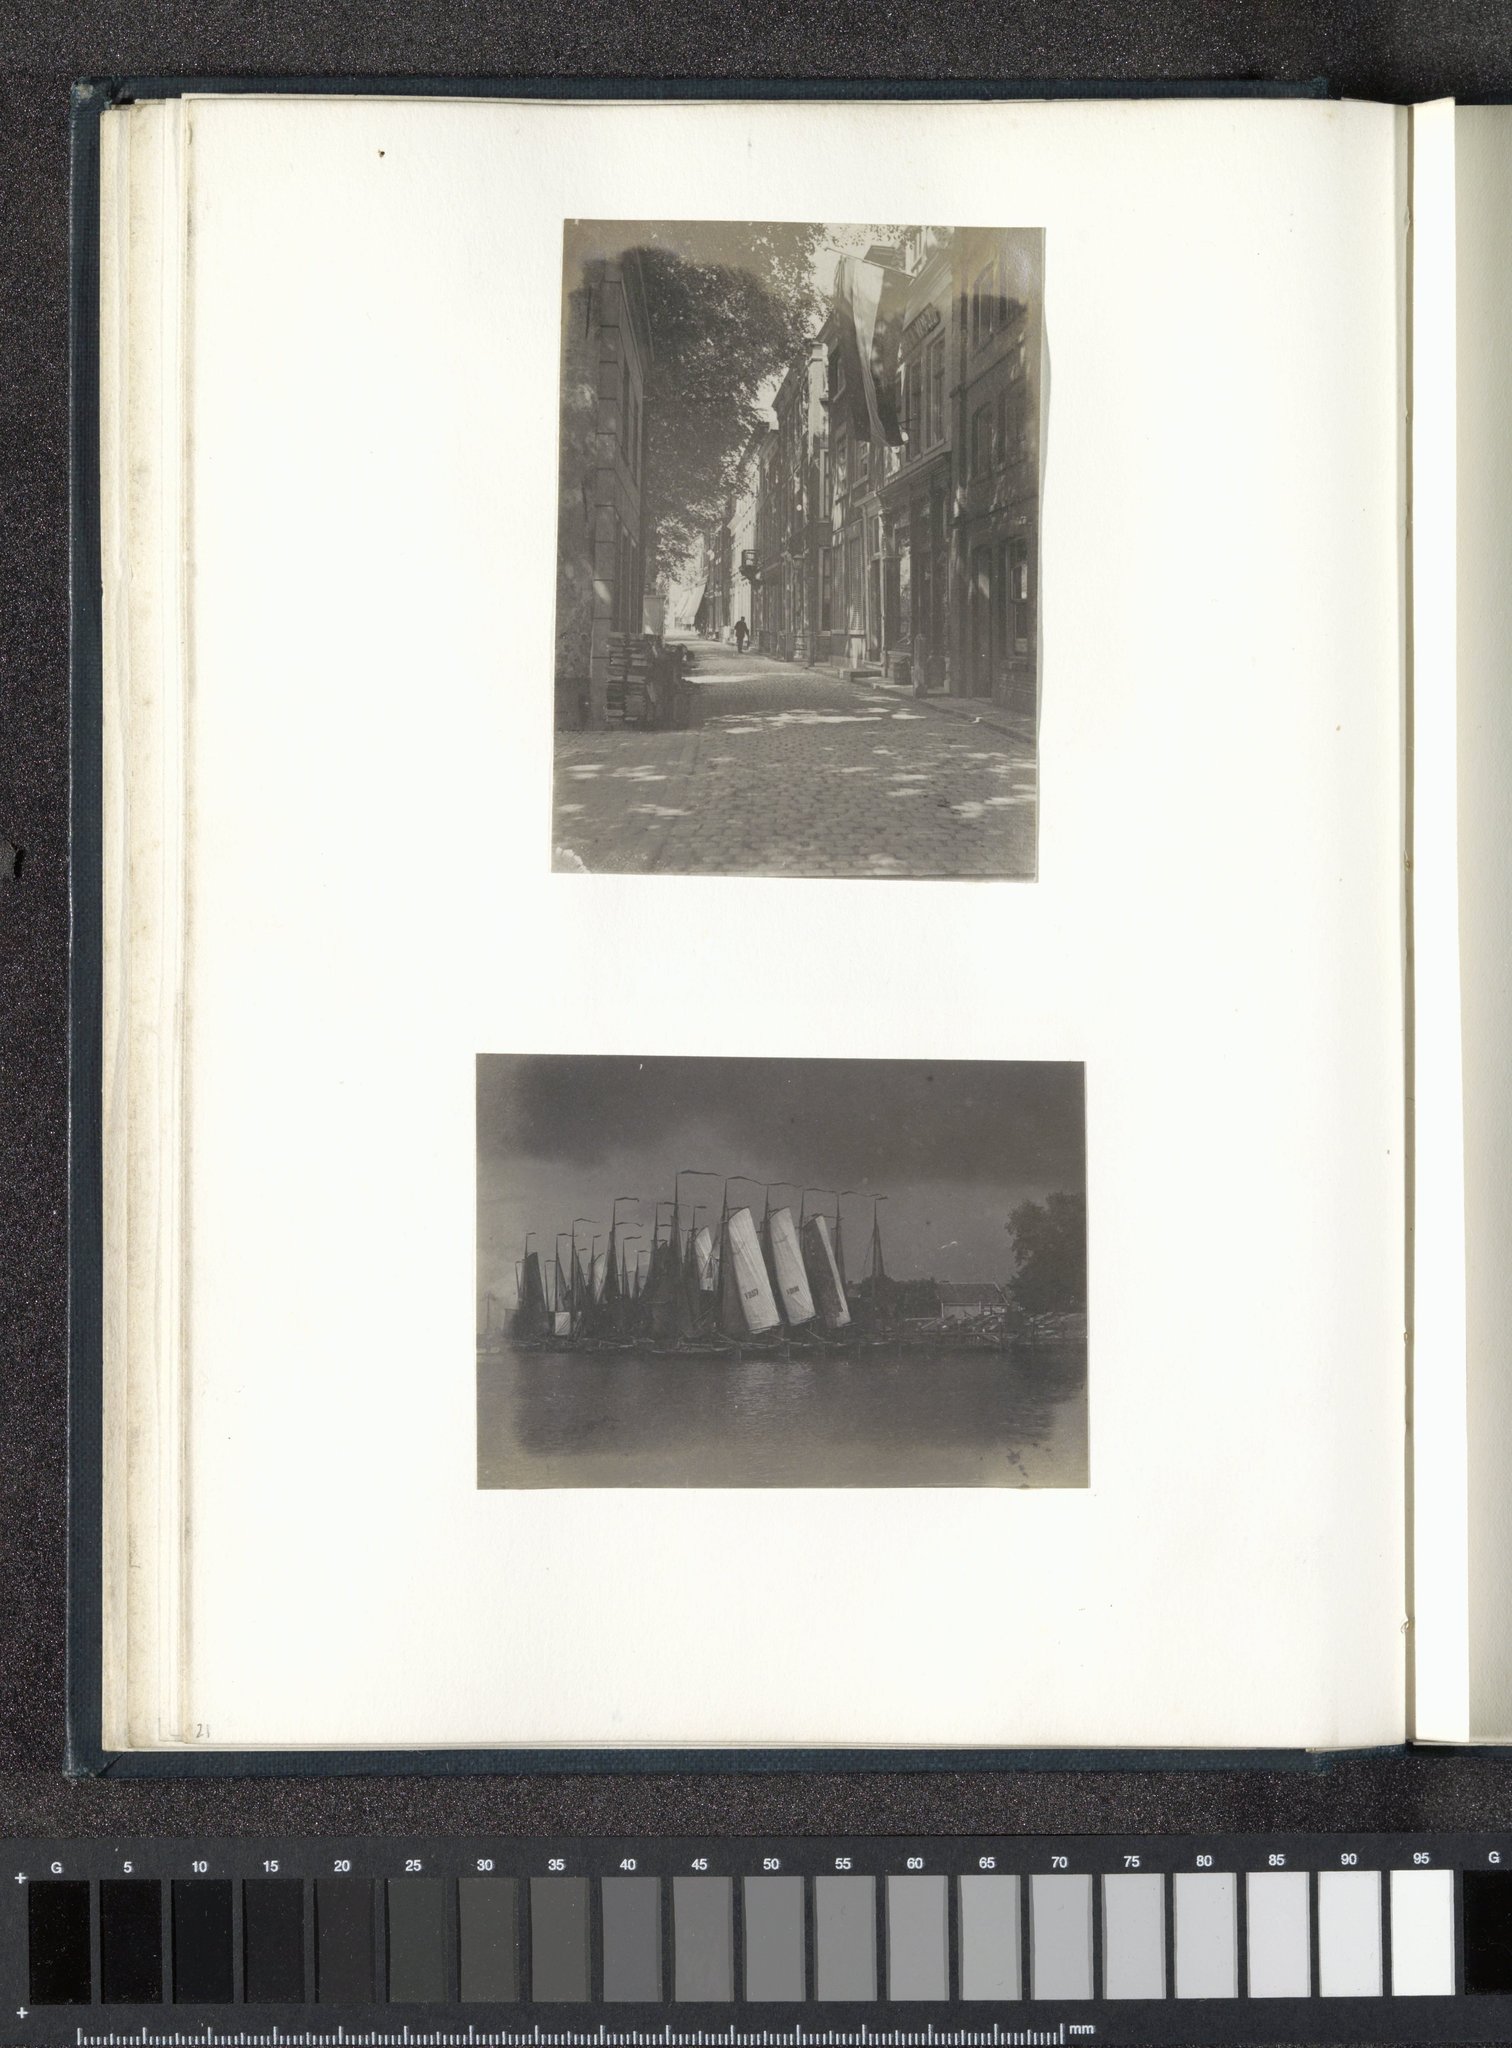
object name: photograph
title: Gezicht op de Appeldijk te Gorinchem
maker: george hidderley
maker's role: fotograaf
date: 1900-1910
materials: paper, photographic support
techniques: gelatin silver print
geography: volendam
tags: flags flown from a mast, village street, the usual house or row of houses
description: Onderdeel van fotoalbum met opnames van Volendam, Dordrecht, Gorinchem en Woudrichem.